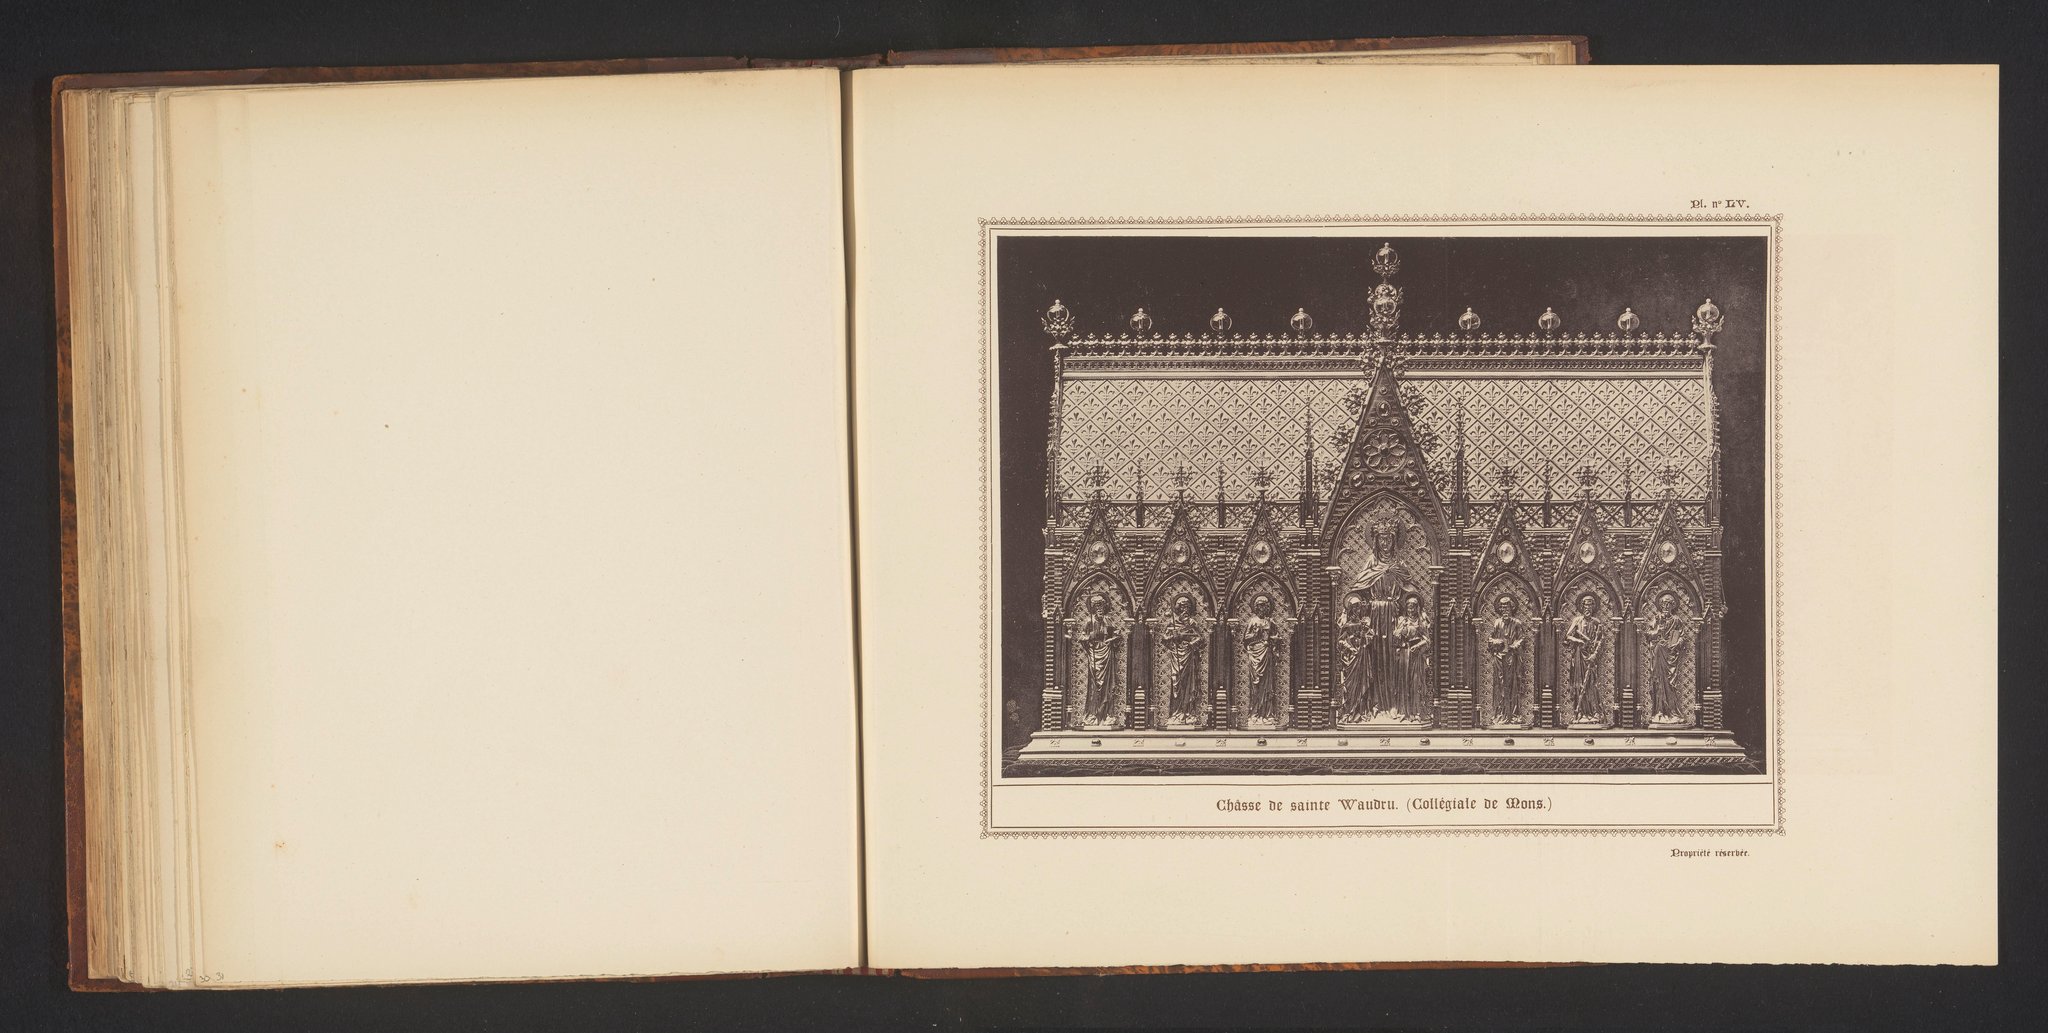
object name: page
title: Chasse de sainte Waudru. (Collégiale de Mons.)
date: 1891-1896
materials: paper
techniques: photograph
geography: bergen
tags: relics (and reliquaries), interior of church, female saints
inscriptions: number: ‘Pl. no LV.’, inscription: ‘Propriété réservée.’